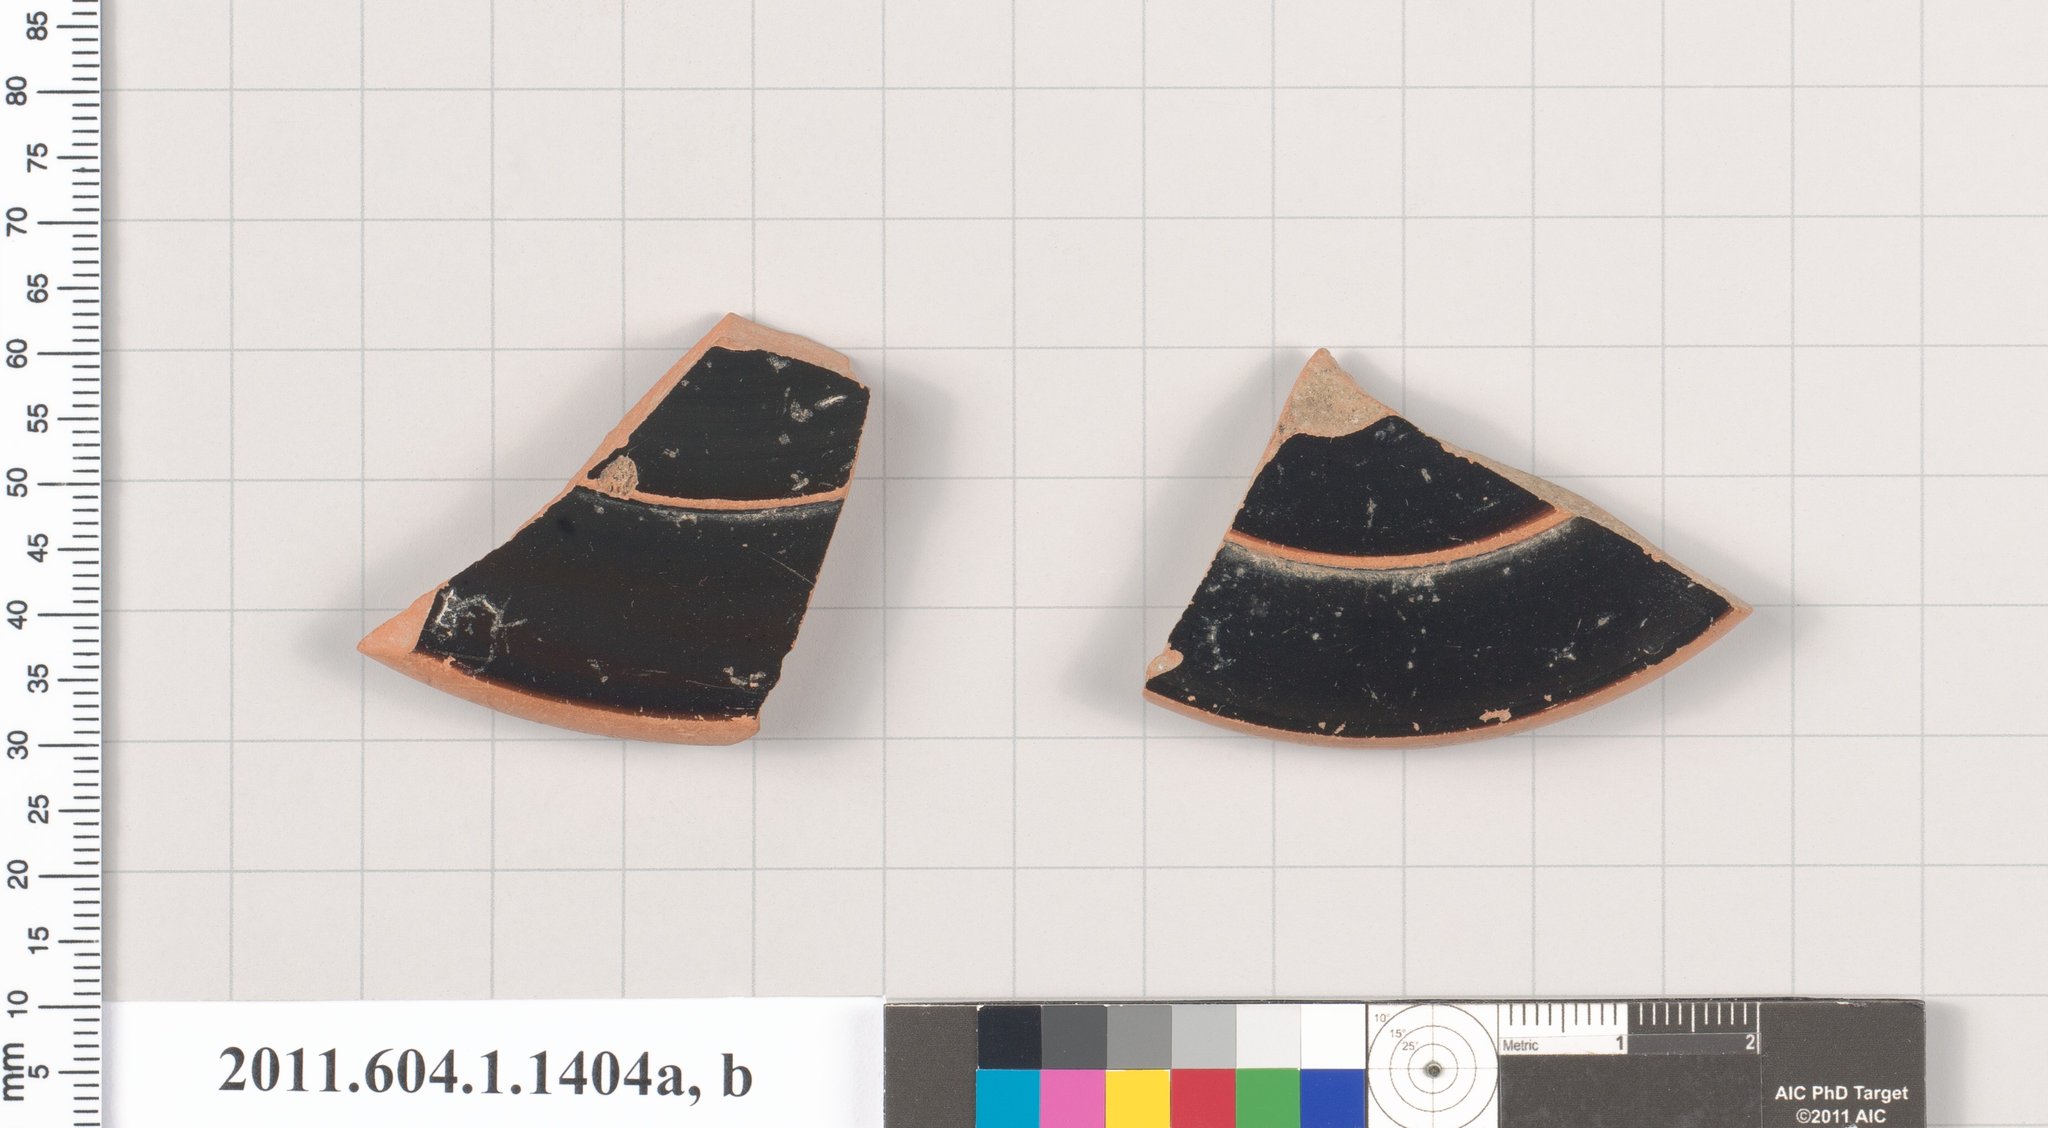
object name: kylix fragment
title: Terracotta fragments of kylikes (drinking cups)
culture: greek, attic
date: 500-401 BCE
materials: terracotta